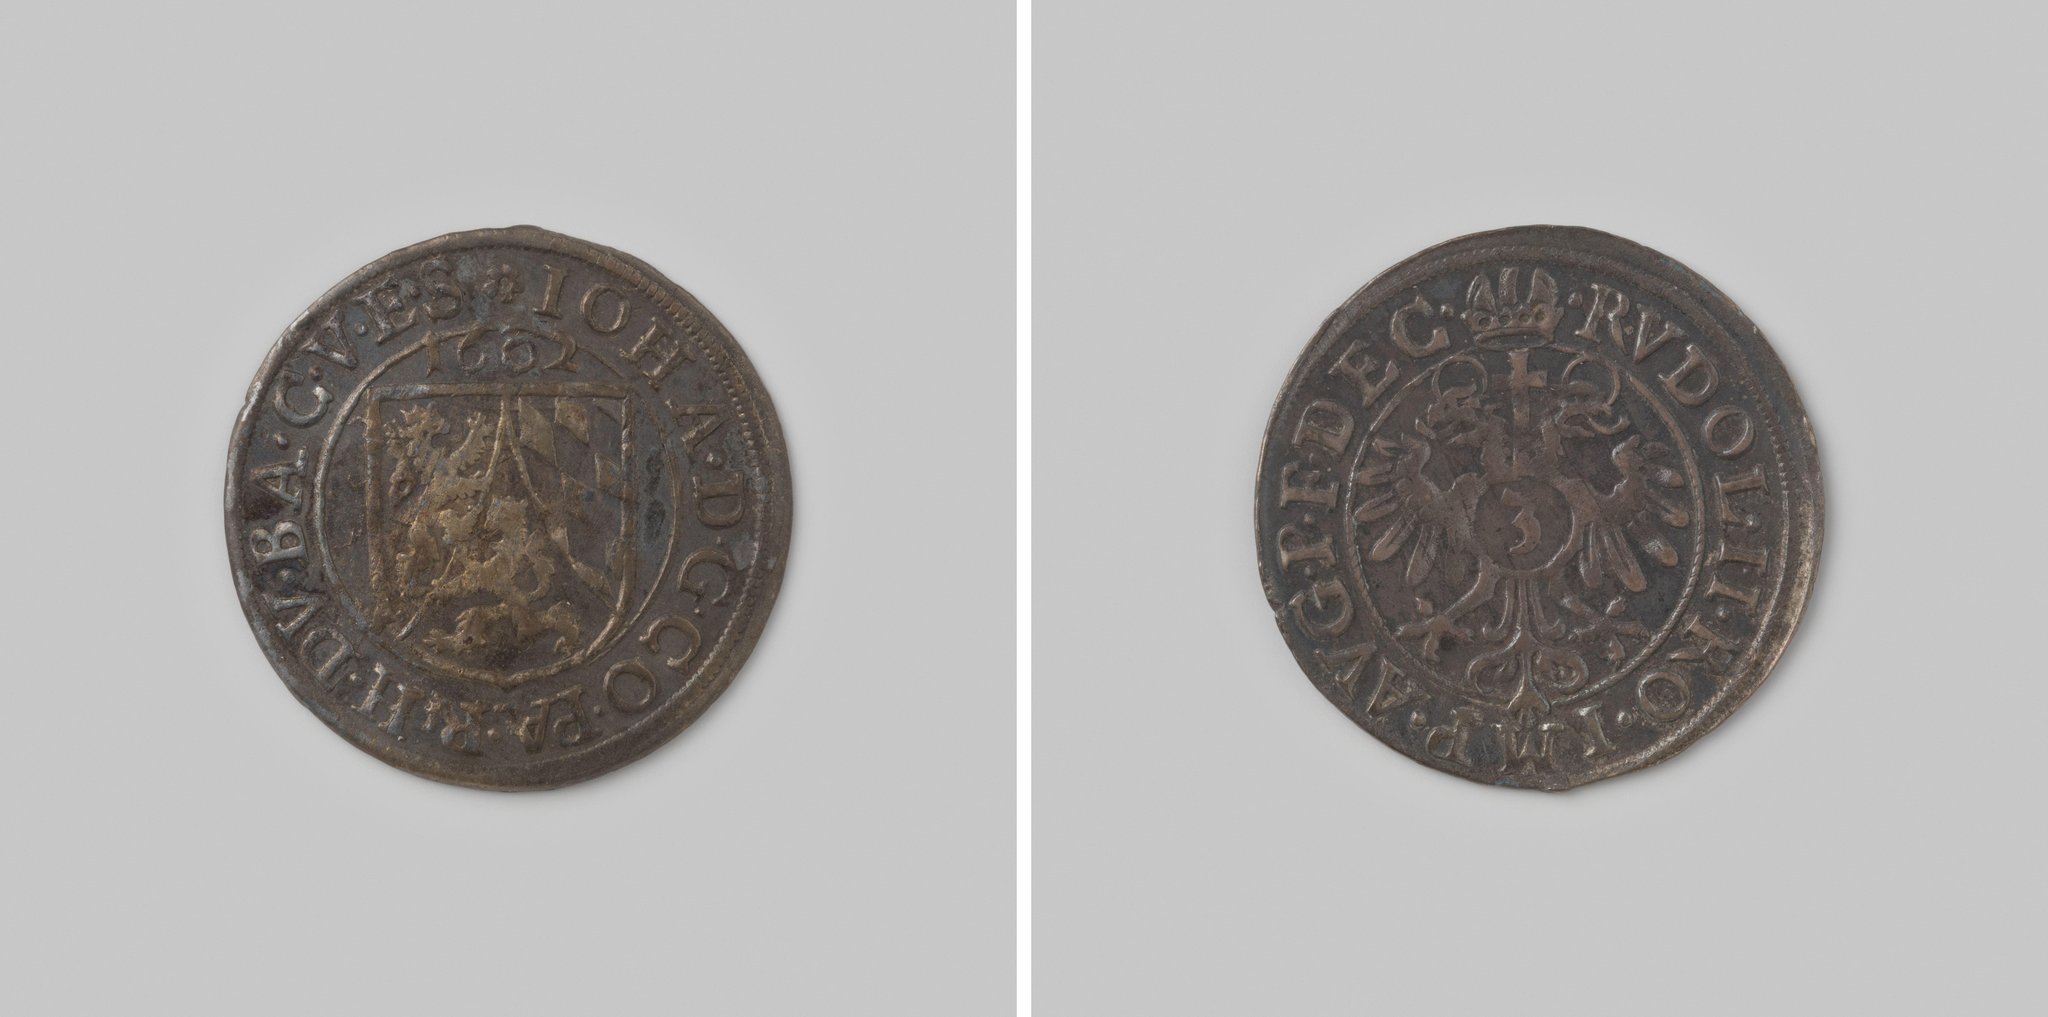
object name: drie kreuzer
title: Palts-Zweibrücken, Johann I, 3 Kreuzer, 1602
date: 1602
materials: silver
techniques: striking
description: Zilveren munt. Voorzijde: samengesteld wapenschild, waarboven jaartal. Keerzijde: gekroonde dubbelkoppige adelaar met op borst cijfer 3 binnen cirkel.